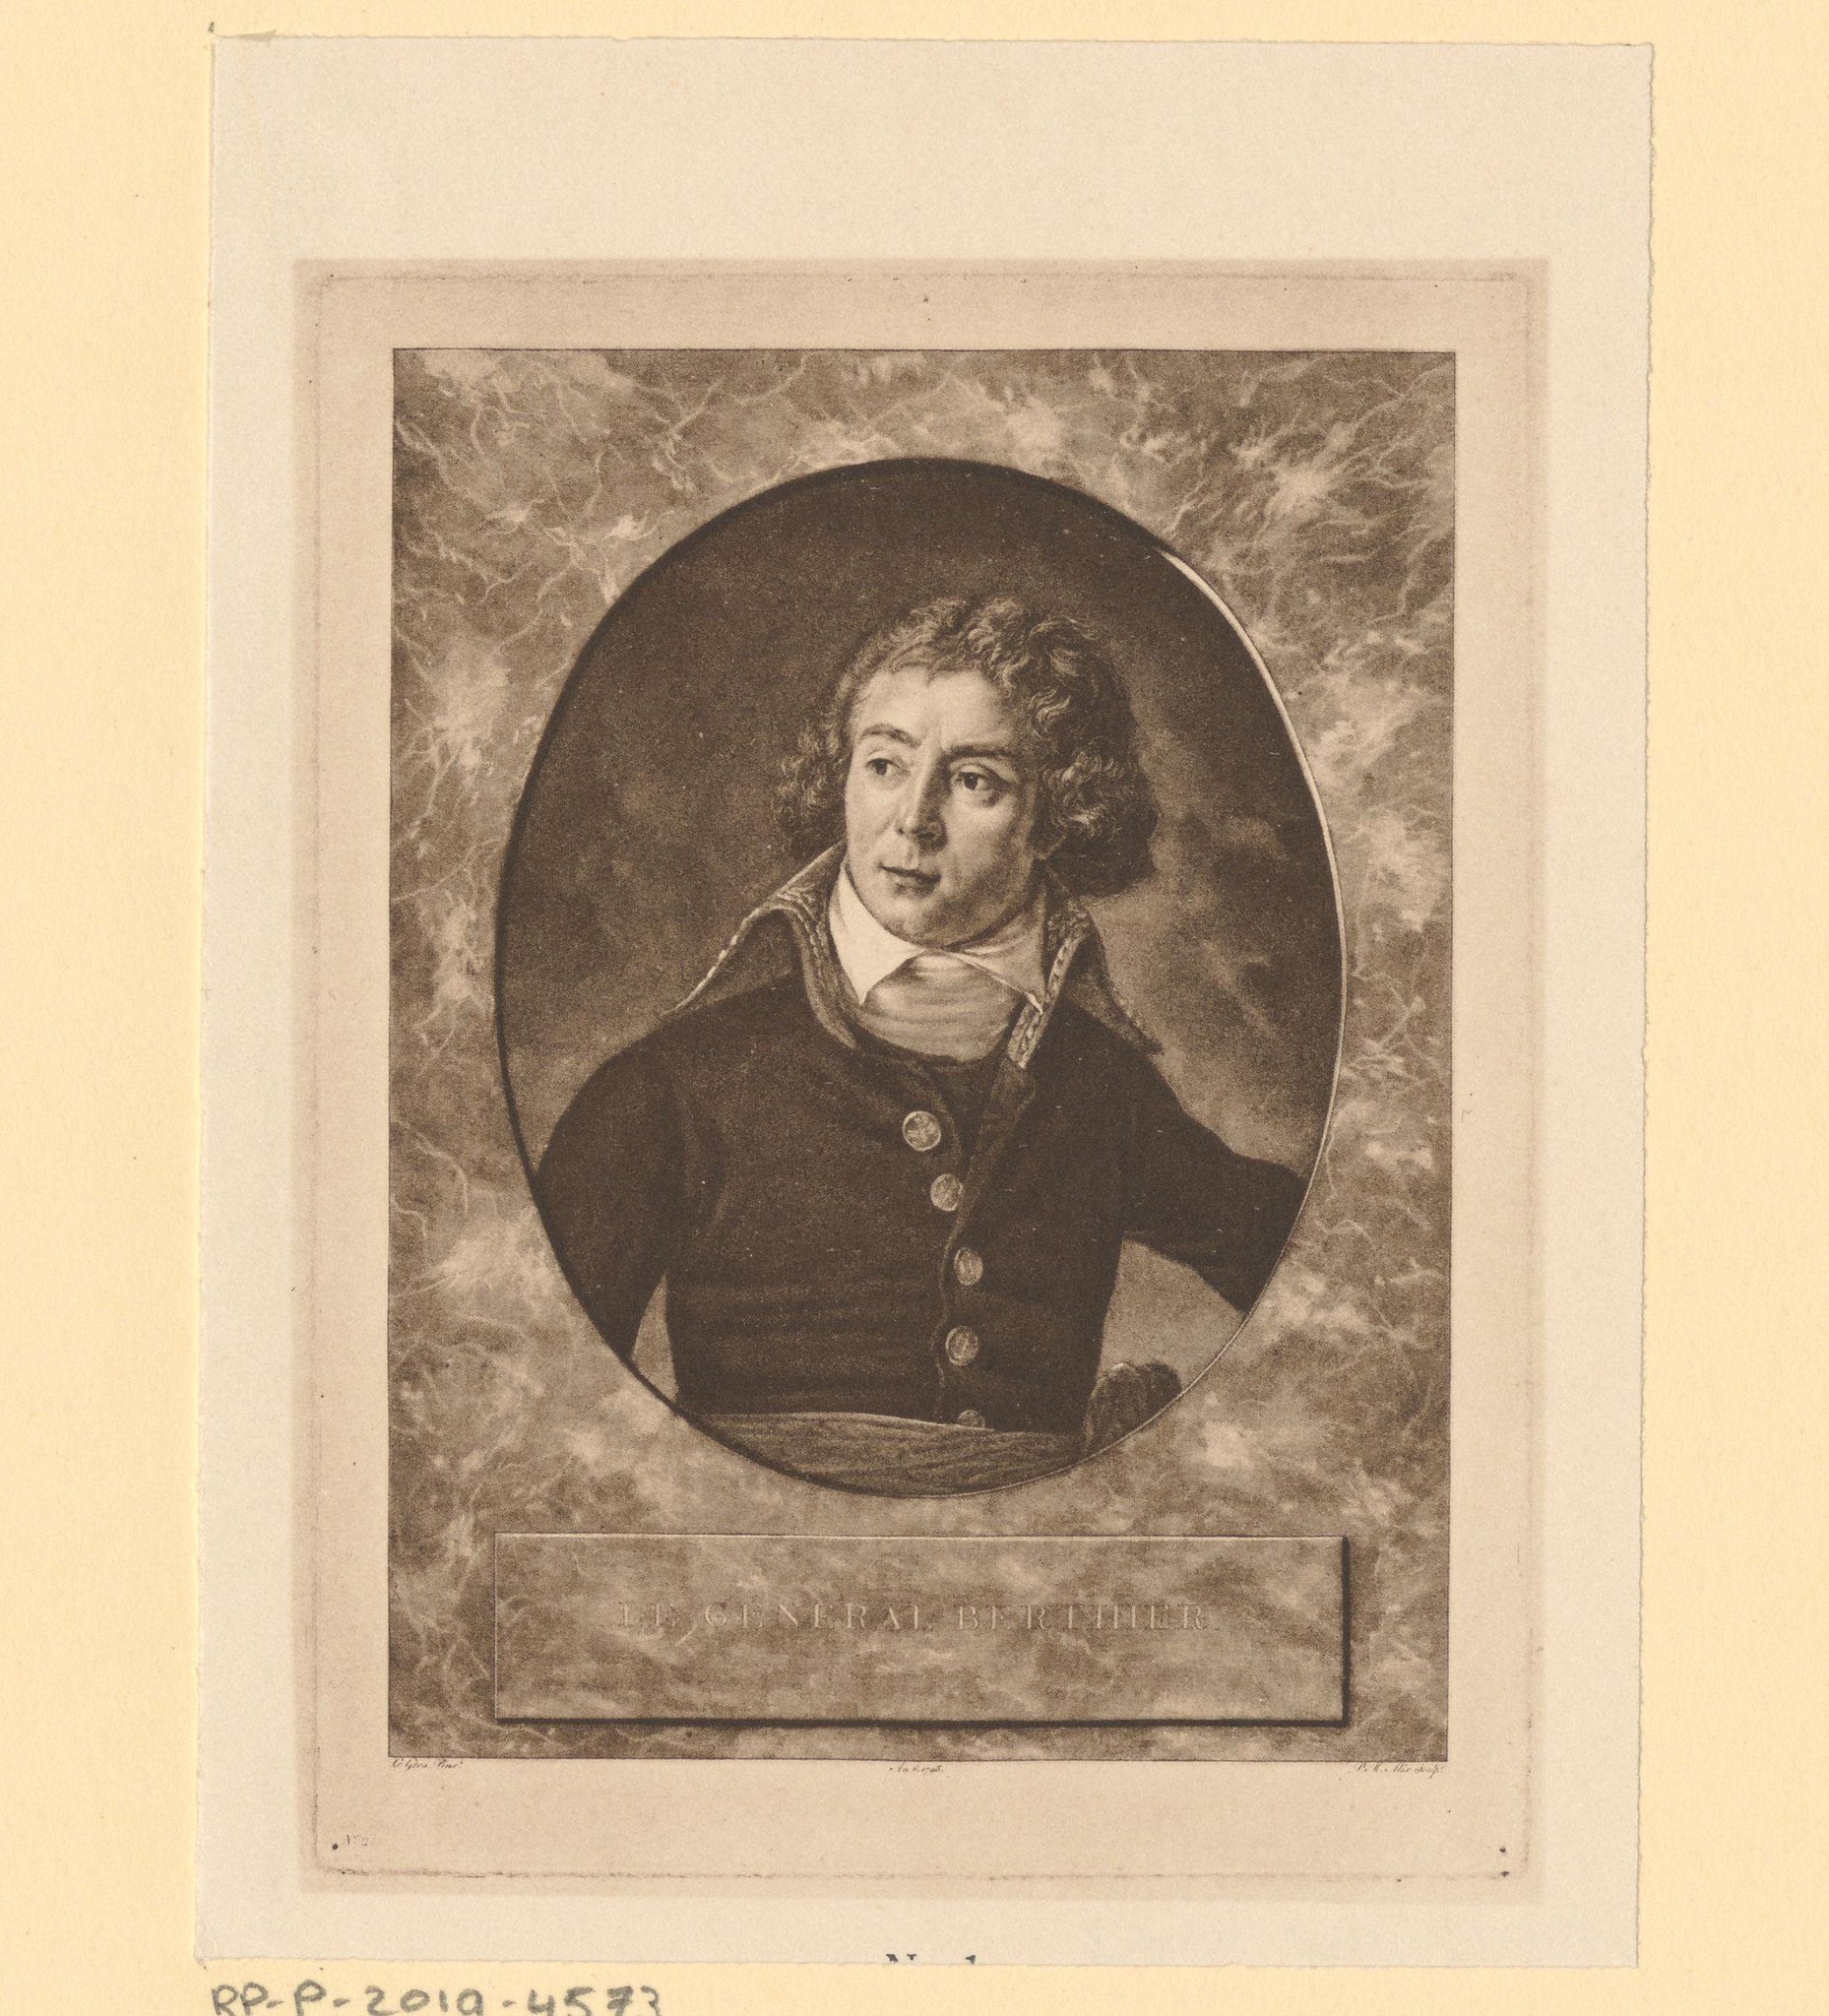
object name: photomechanical print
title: Portret van Louis-Alexandre Berthier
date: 1900-1949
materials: paper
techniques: photoaquatint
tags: historical persons